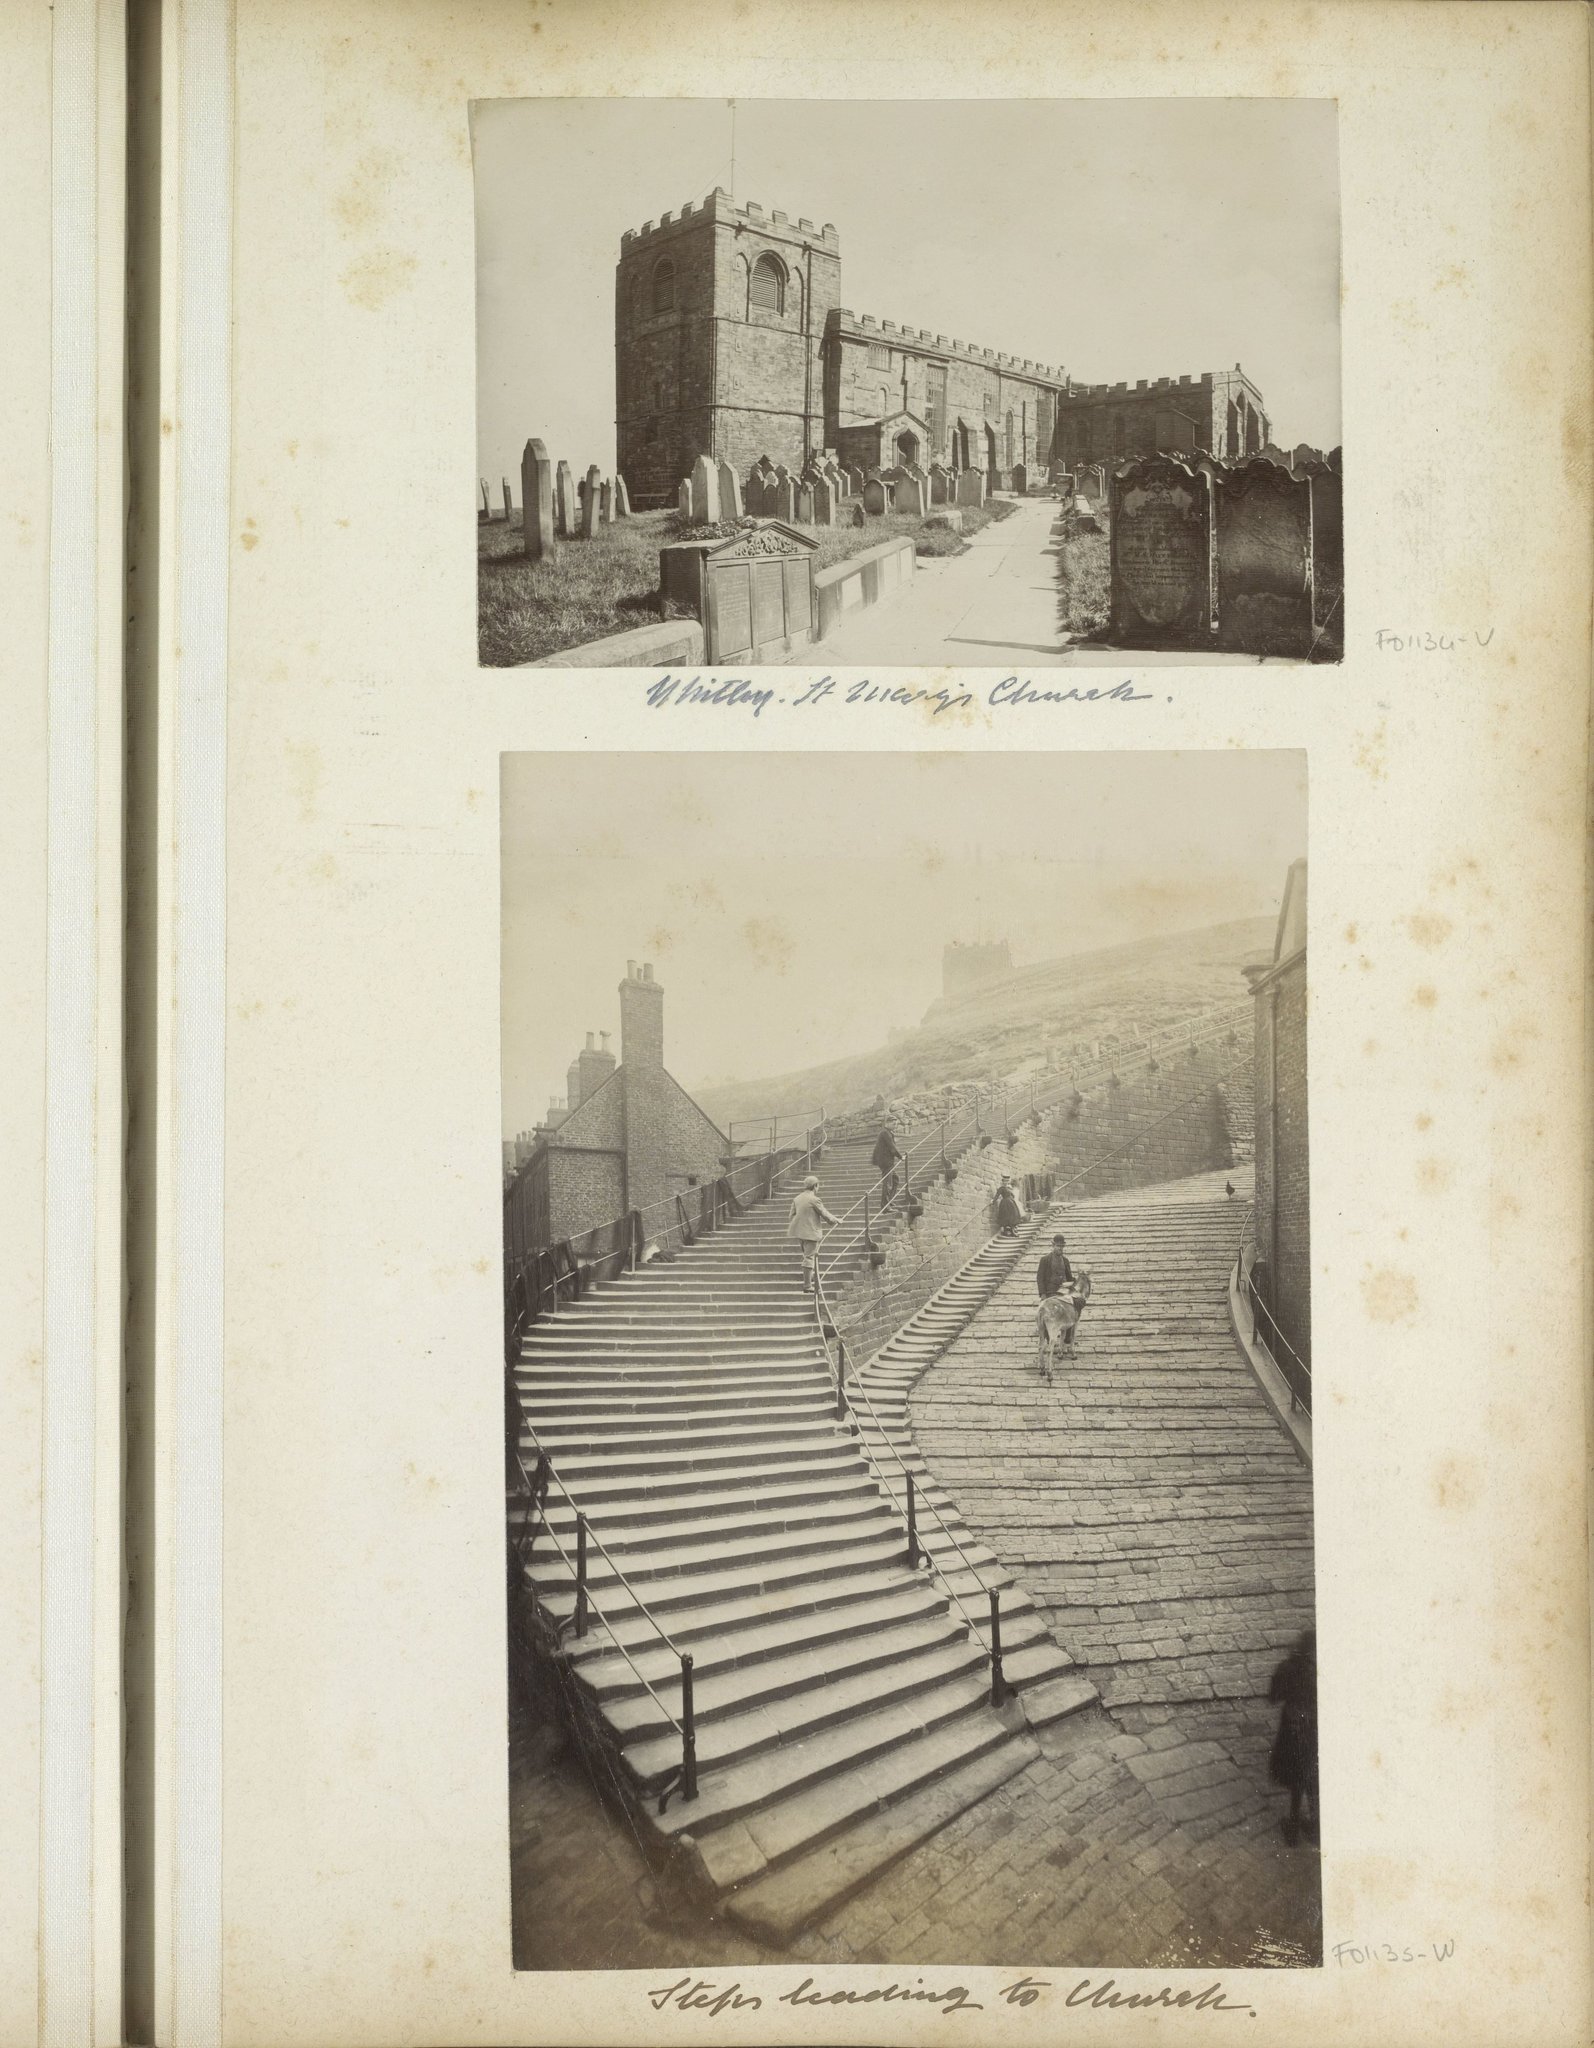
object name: photograph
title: Kerktrappen van St. Mary's Church in Whitby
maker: Anonymous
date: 1898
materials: paper, photographic support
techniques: albumen print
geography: whitby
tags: ass, donkey, sloping street; street with steps or stairs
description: Onderdeel van Reisalbum met foto's van bezienswaardigheden in Engeland en Frankrijk.